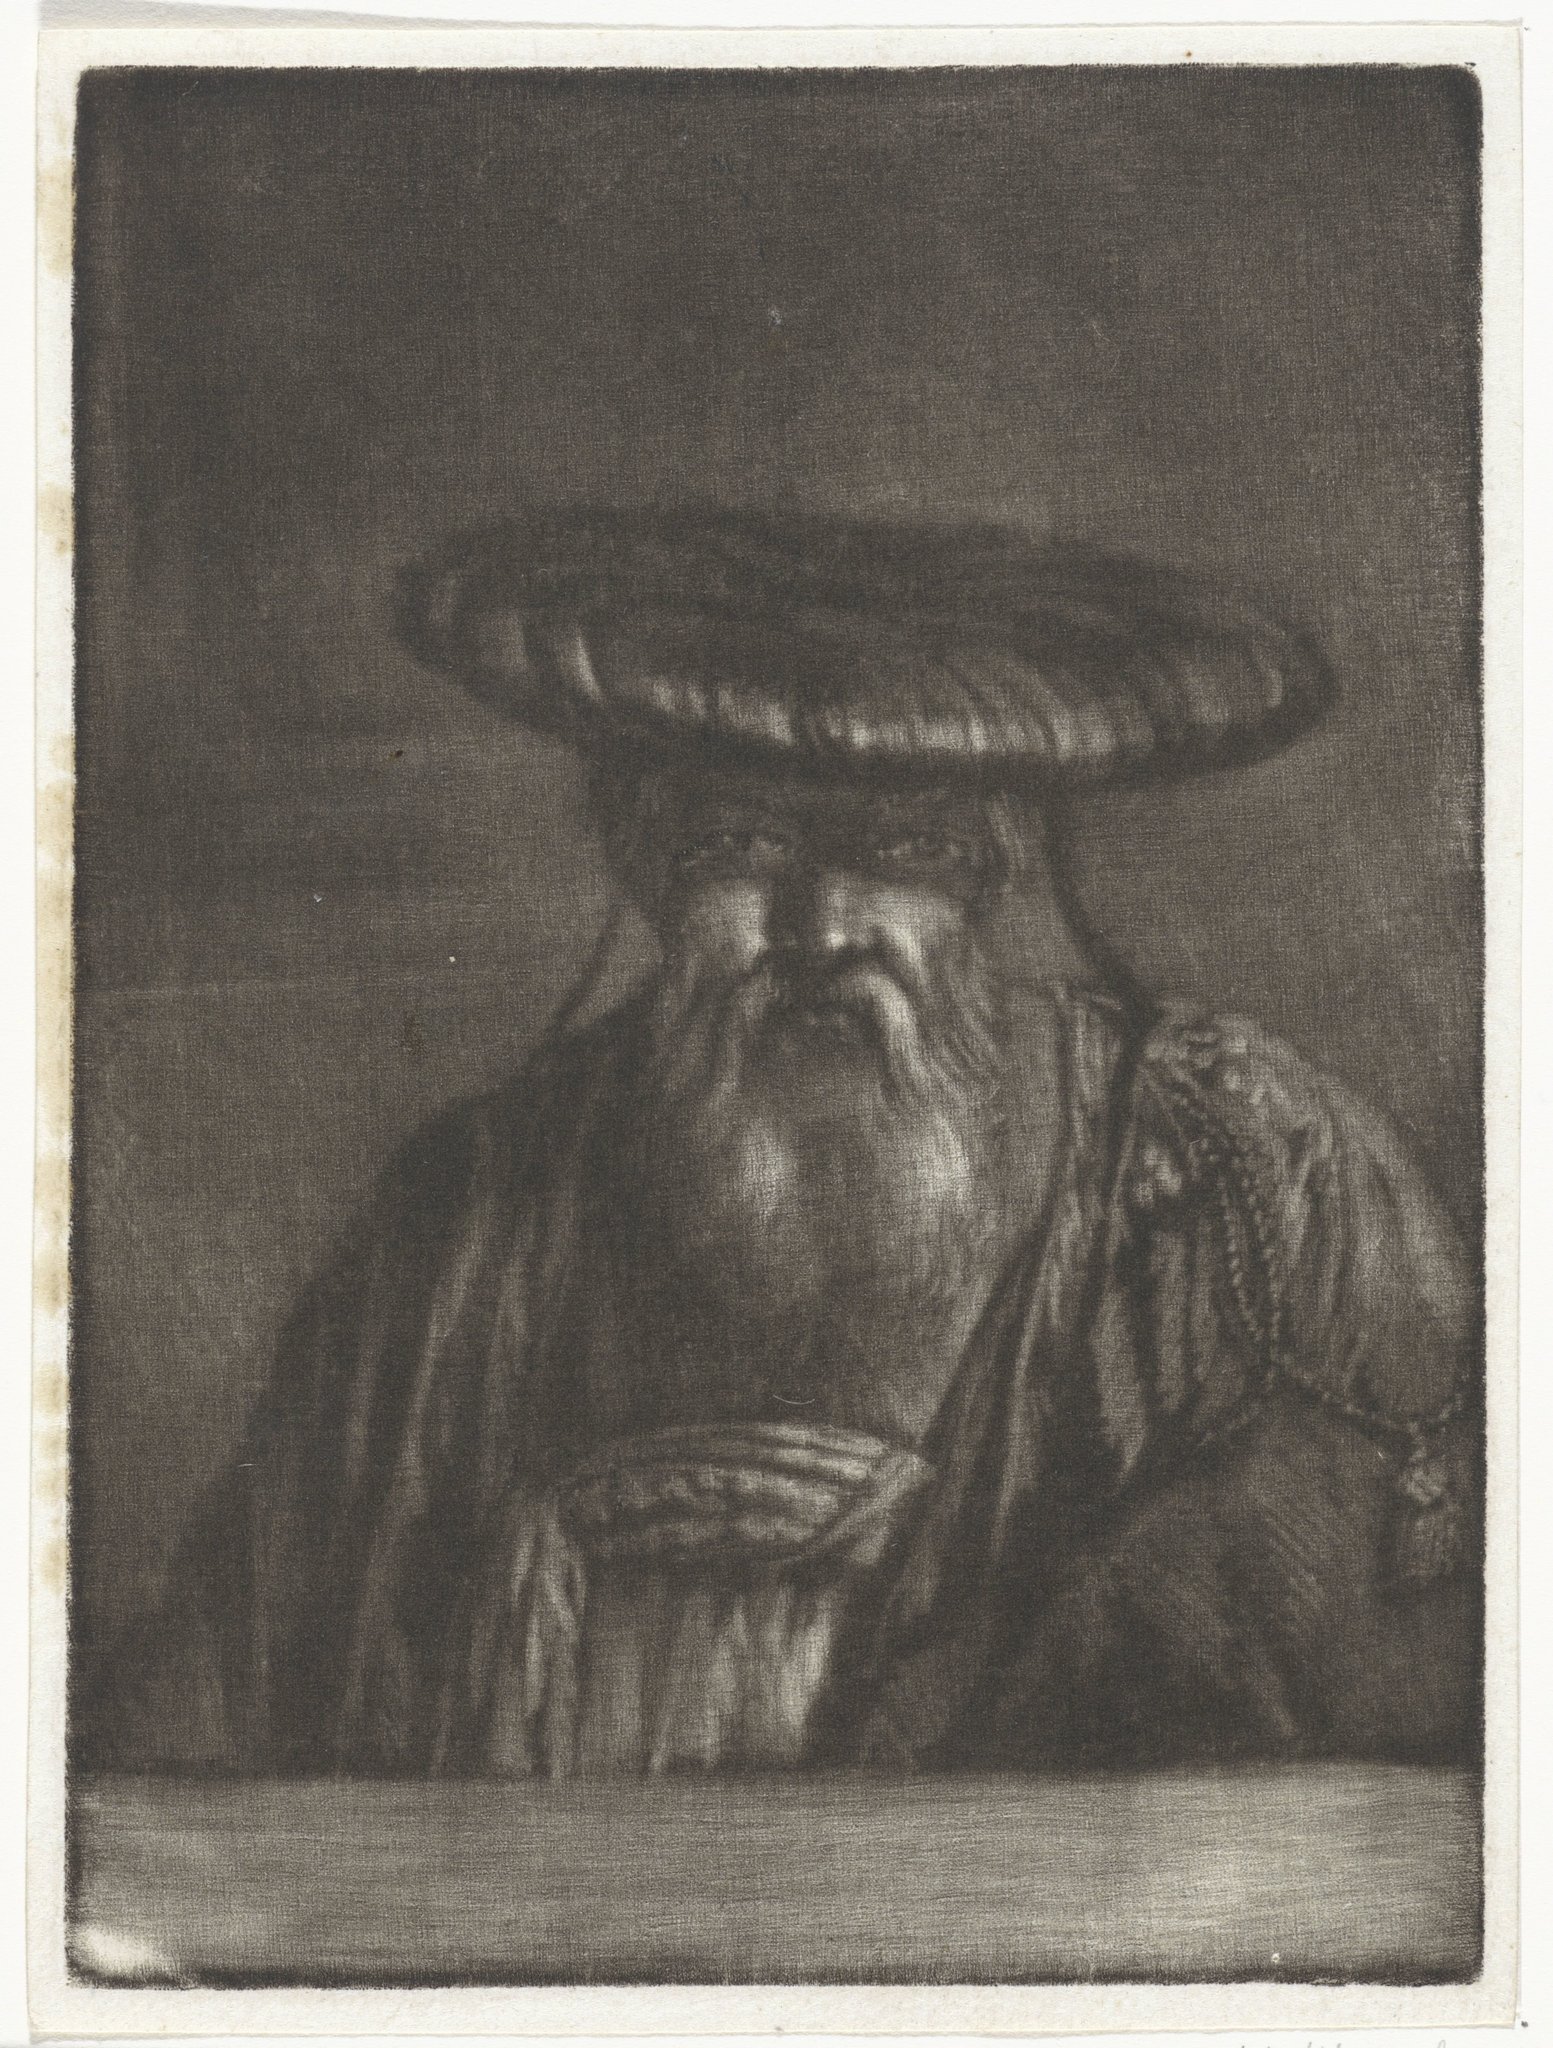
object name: print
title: Portret van een oude man met een platte brede muts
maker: cornelis ploos van amstel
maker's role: draughtsman, print maker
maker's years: 1726-1798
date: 1756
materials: paper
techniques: mezzotint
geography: amsterdam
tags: head-gear: cap (+ men's clothes)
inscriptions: collector's mark: Lugt 2228